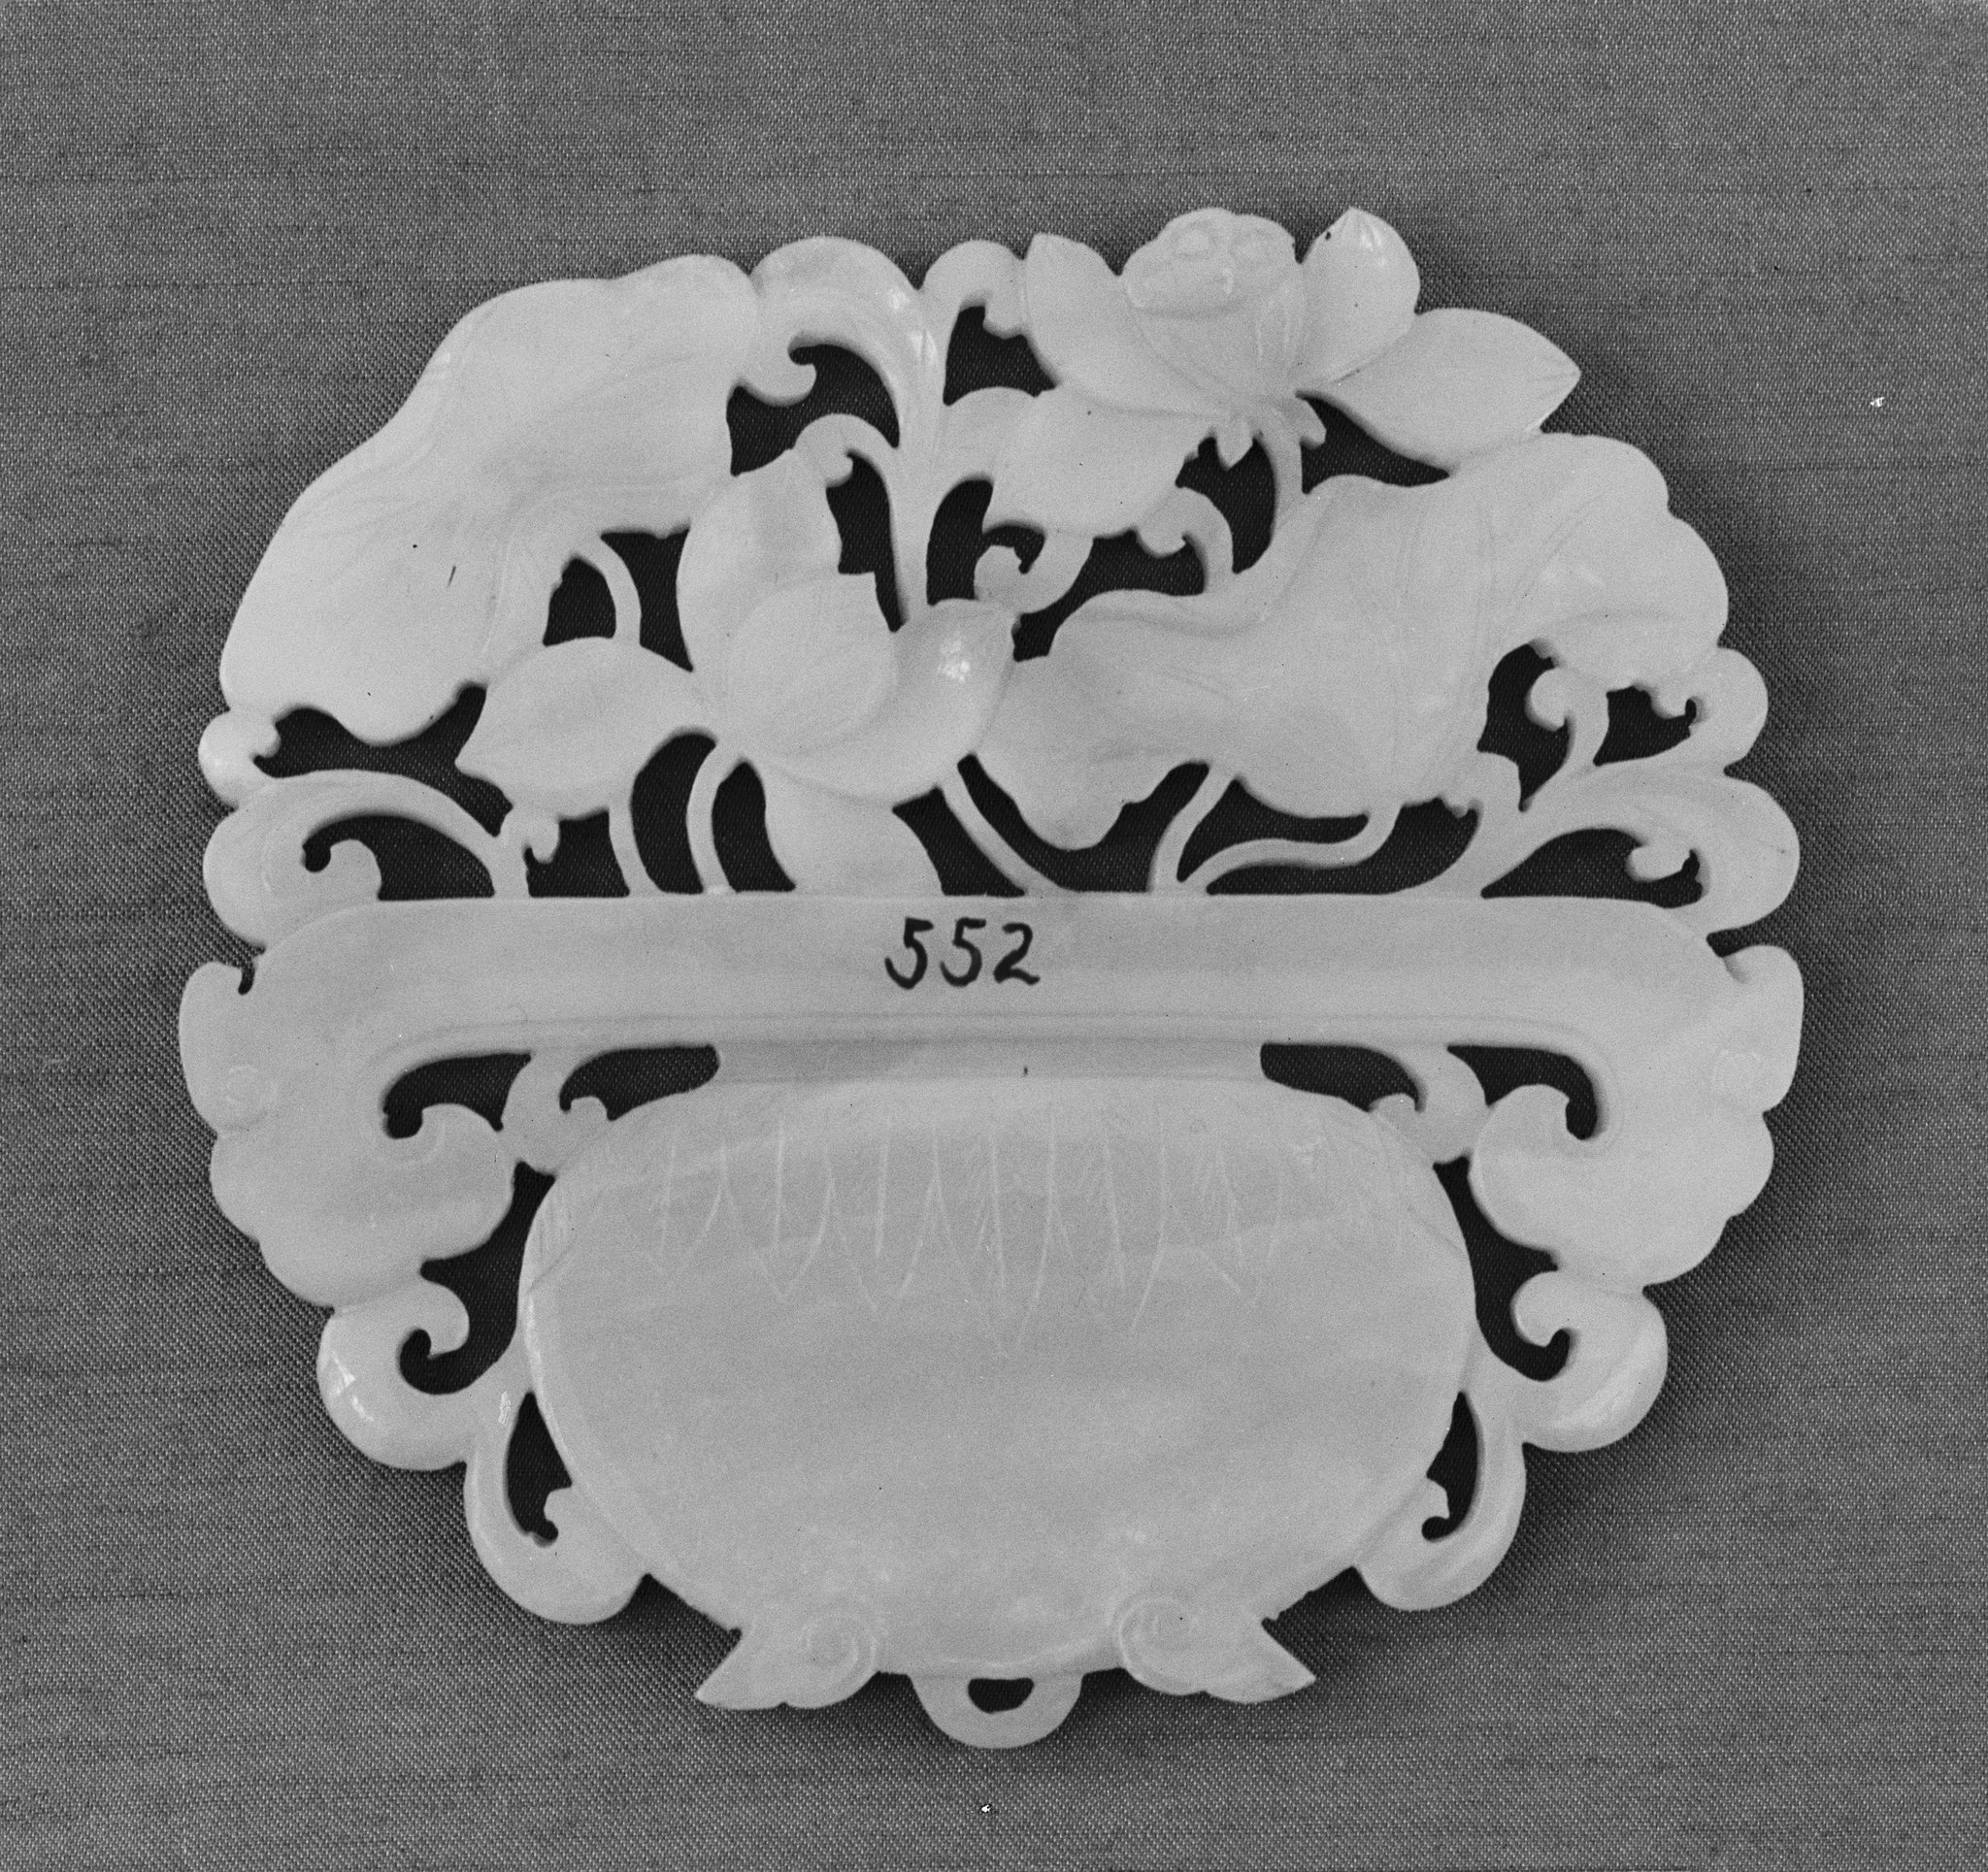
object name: medallion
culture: chinese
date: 1736-1795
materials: jade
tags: flowers